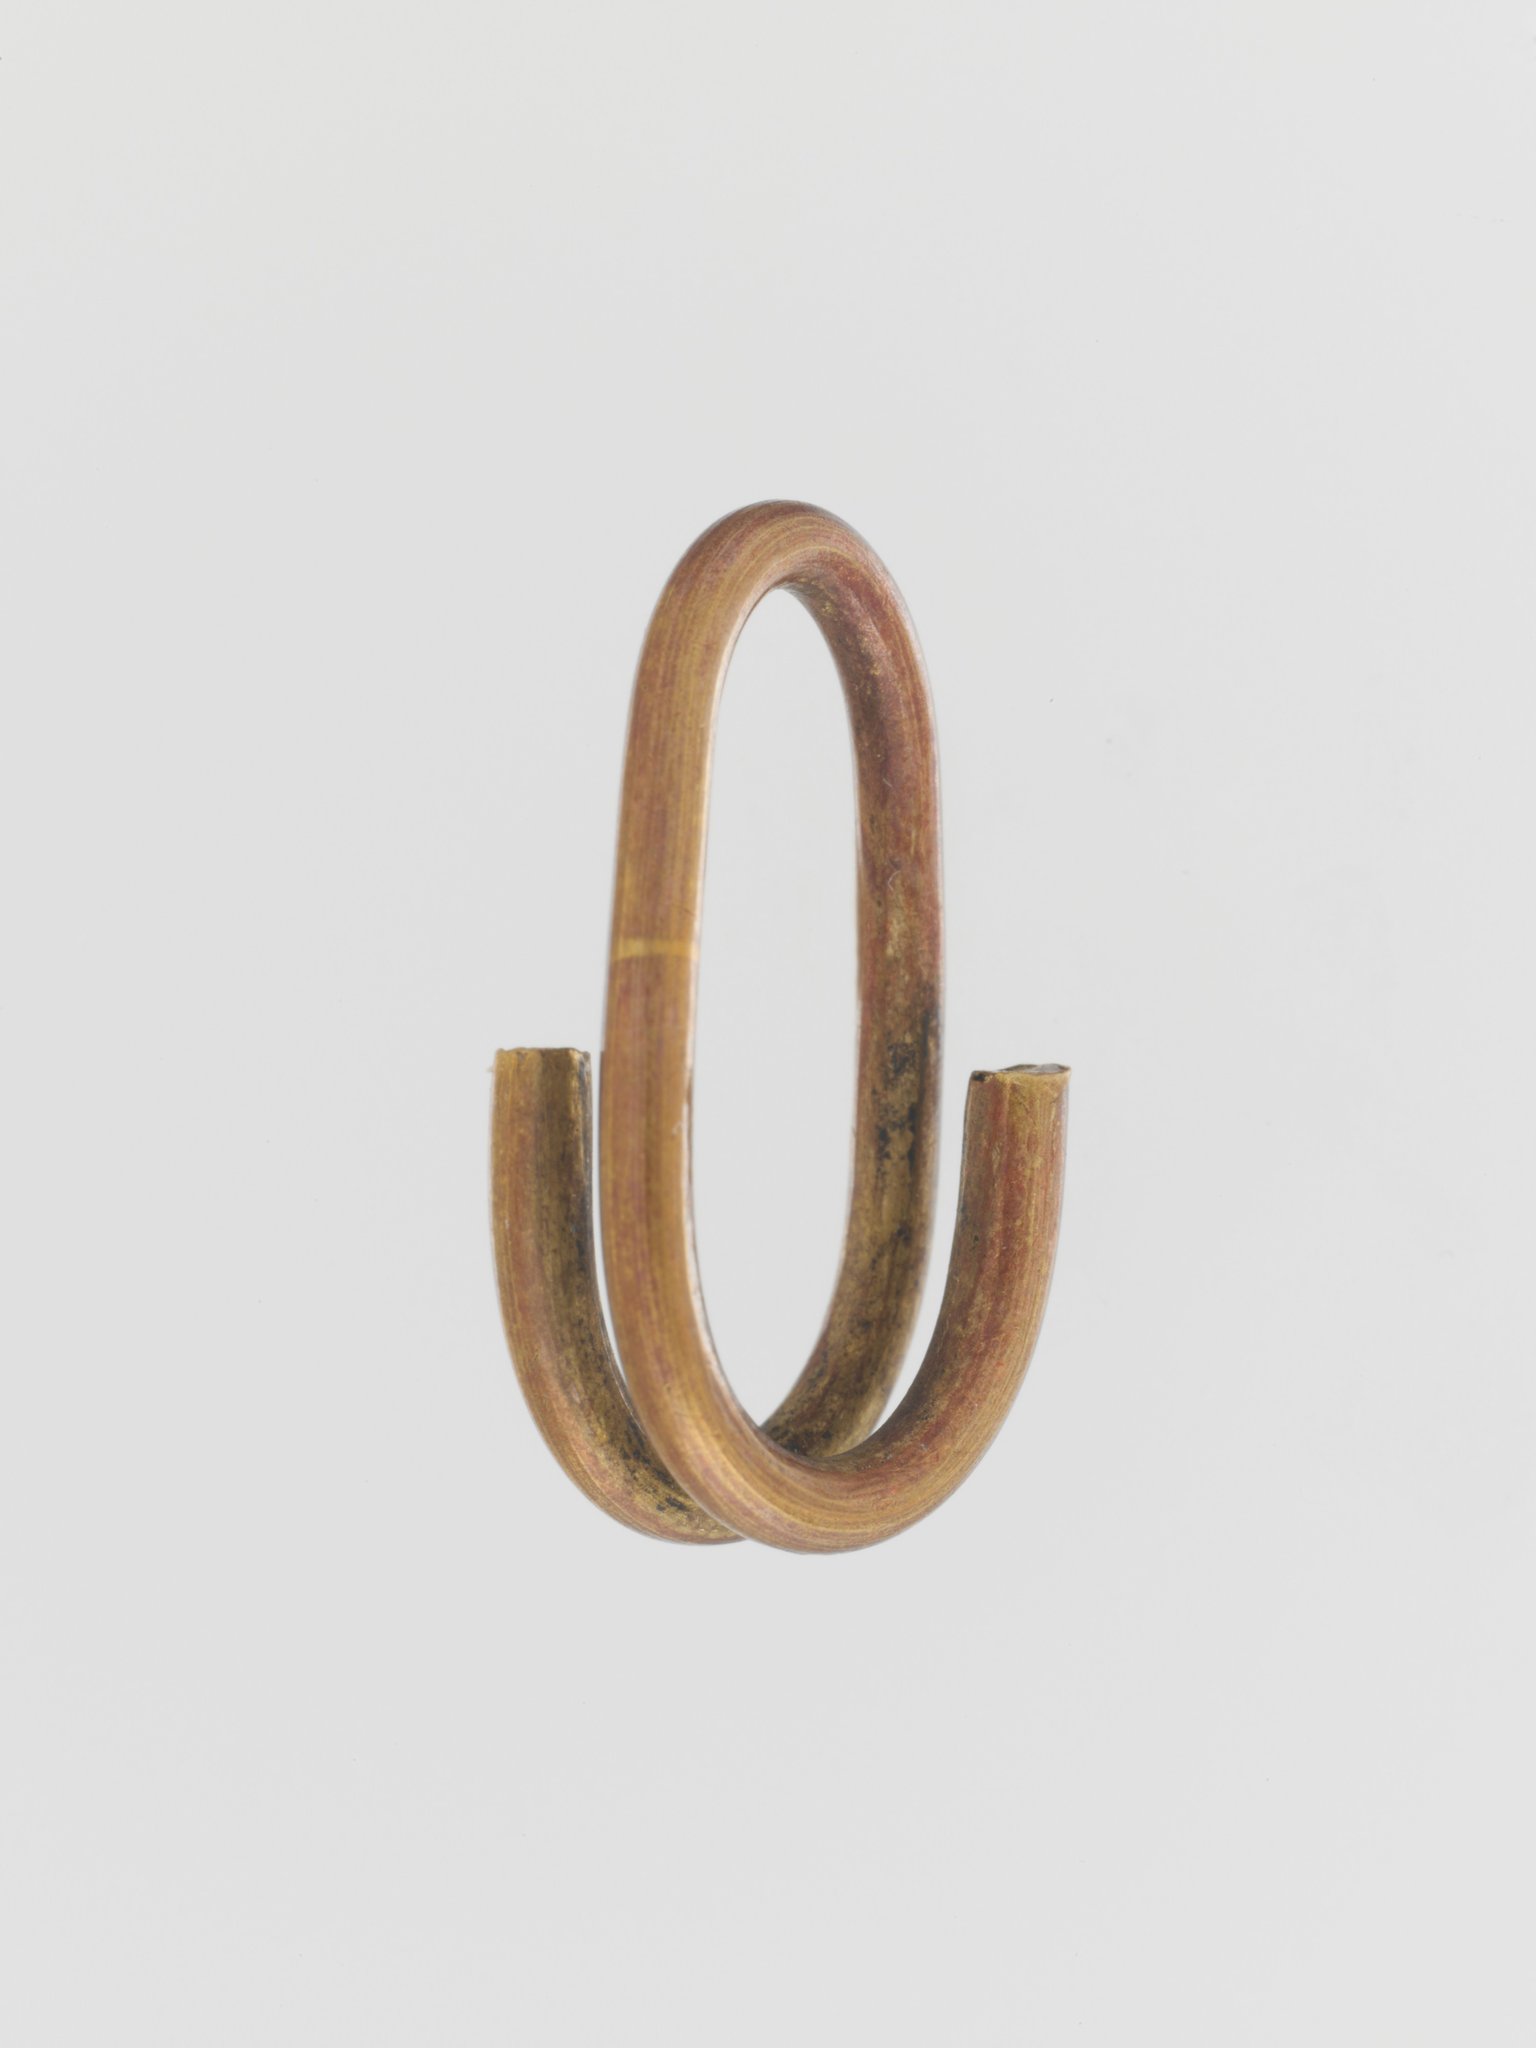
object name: earring or spiral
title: Gold spiral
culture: cypriot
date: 1600-1100 BCE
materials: gold